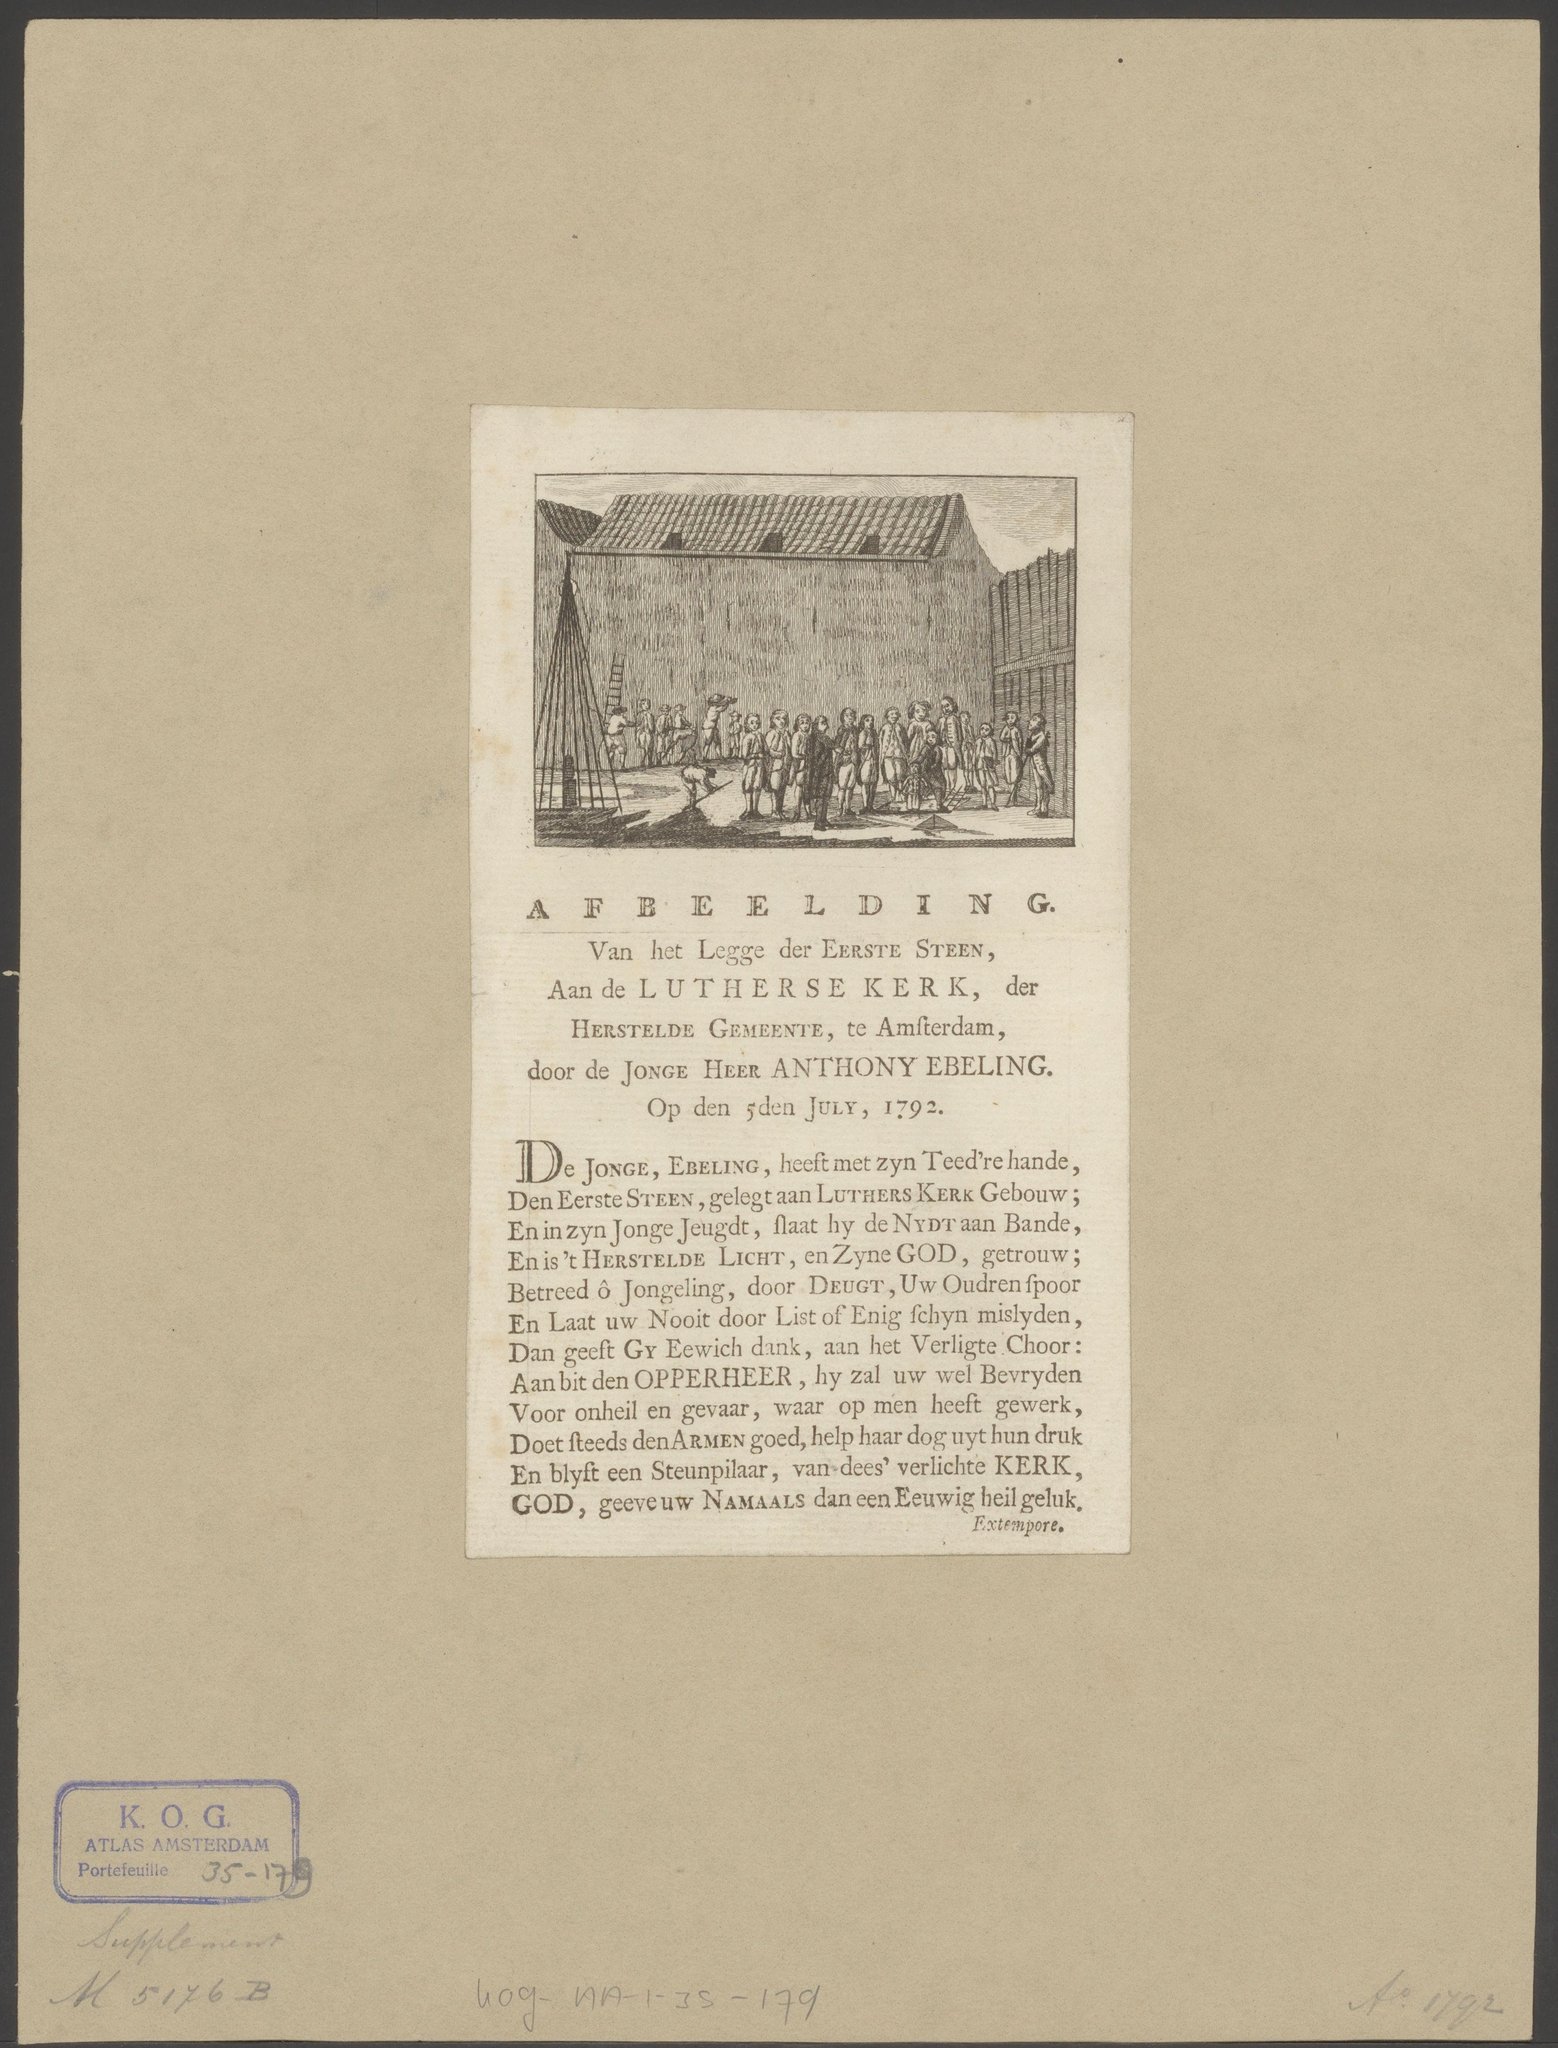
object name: print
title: Afbeelding. Van het Legge der Eerste Steen, Aan de Lutherse Kerk (...)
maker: Anonymous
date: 1792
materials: paper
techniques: etching, letterpress printing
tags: ceremonial laying of the foundations, laying the first stone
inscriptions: collector's mark: Lugt 1641b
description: Eerstesteenlegging van de Hersteld Evangelisch Lutherse Kerk op 5 juli 1792. Onderwerpsrubriek binnen de Atlas Amsterdam: Kerkwezen: Ev. Lutherse Gemeente: Herst. Ev. Luth. Gemeente.